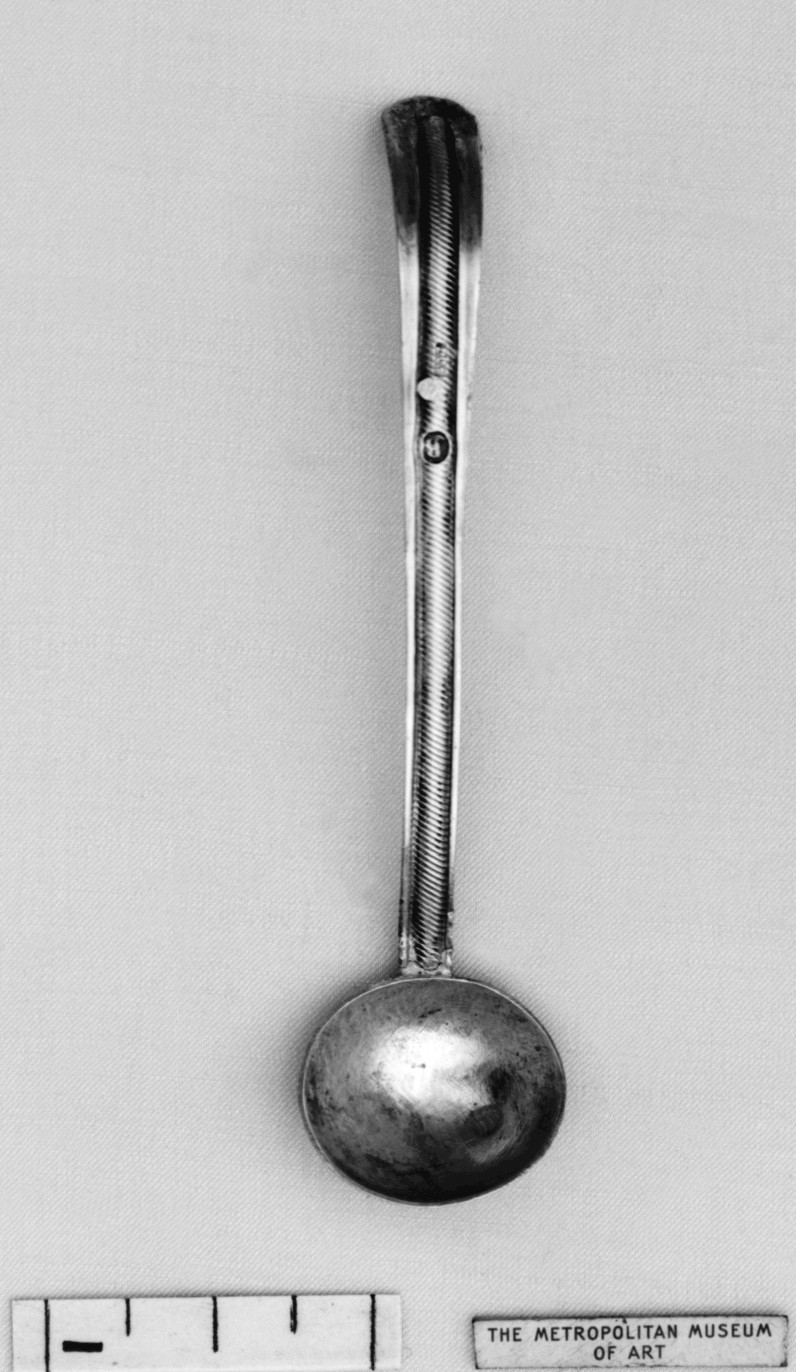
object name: mustard spoon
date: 1801-1900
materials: gilt, silver